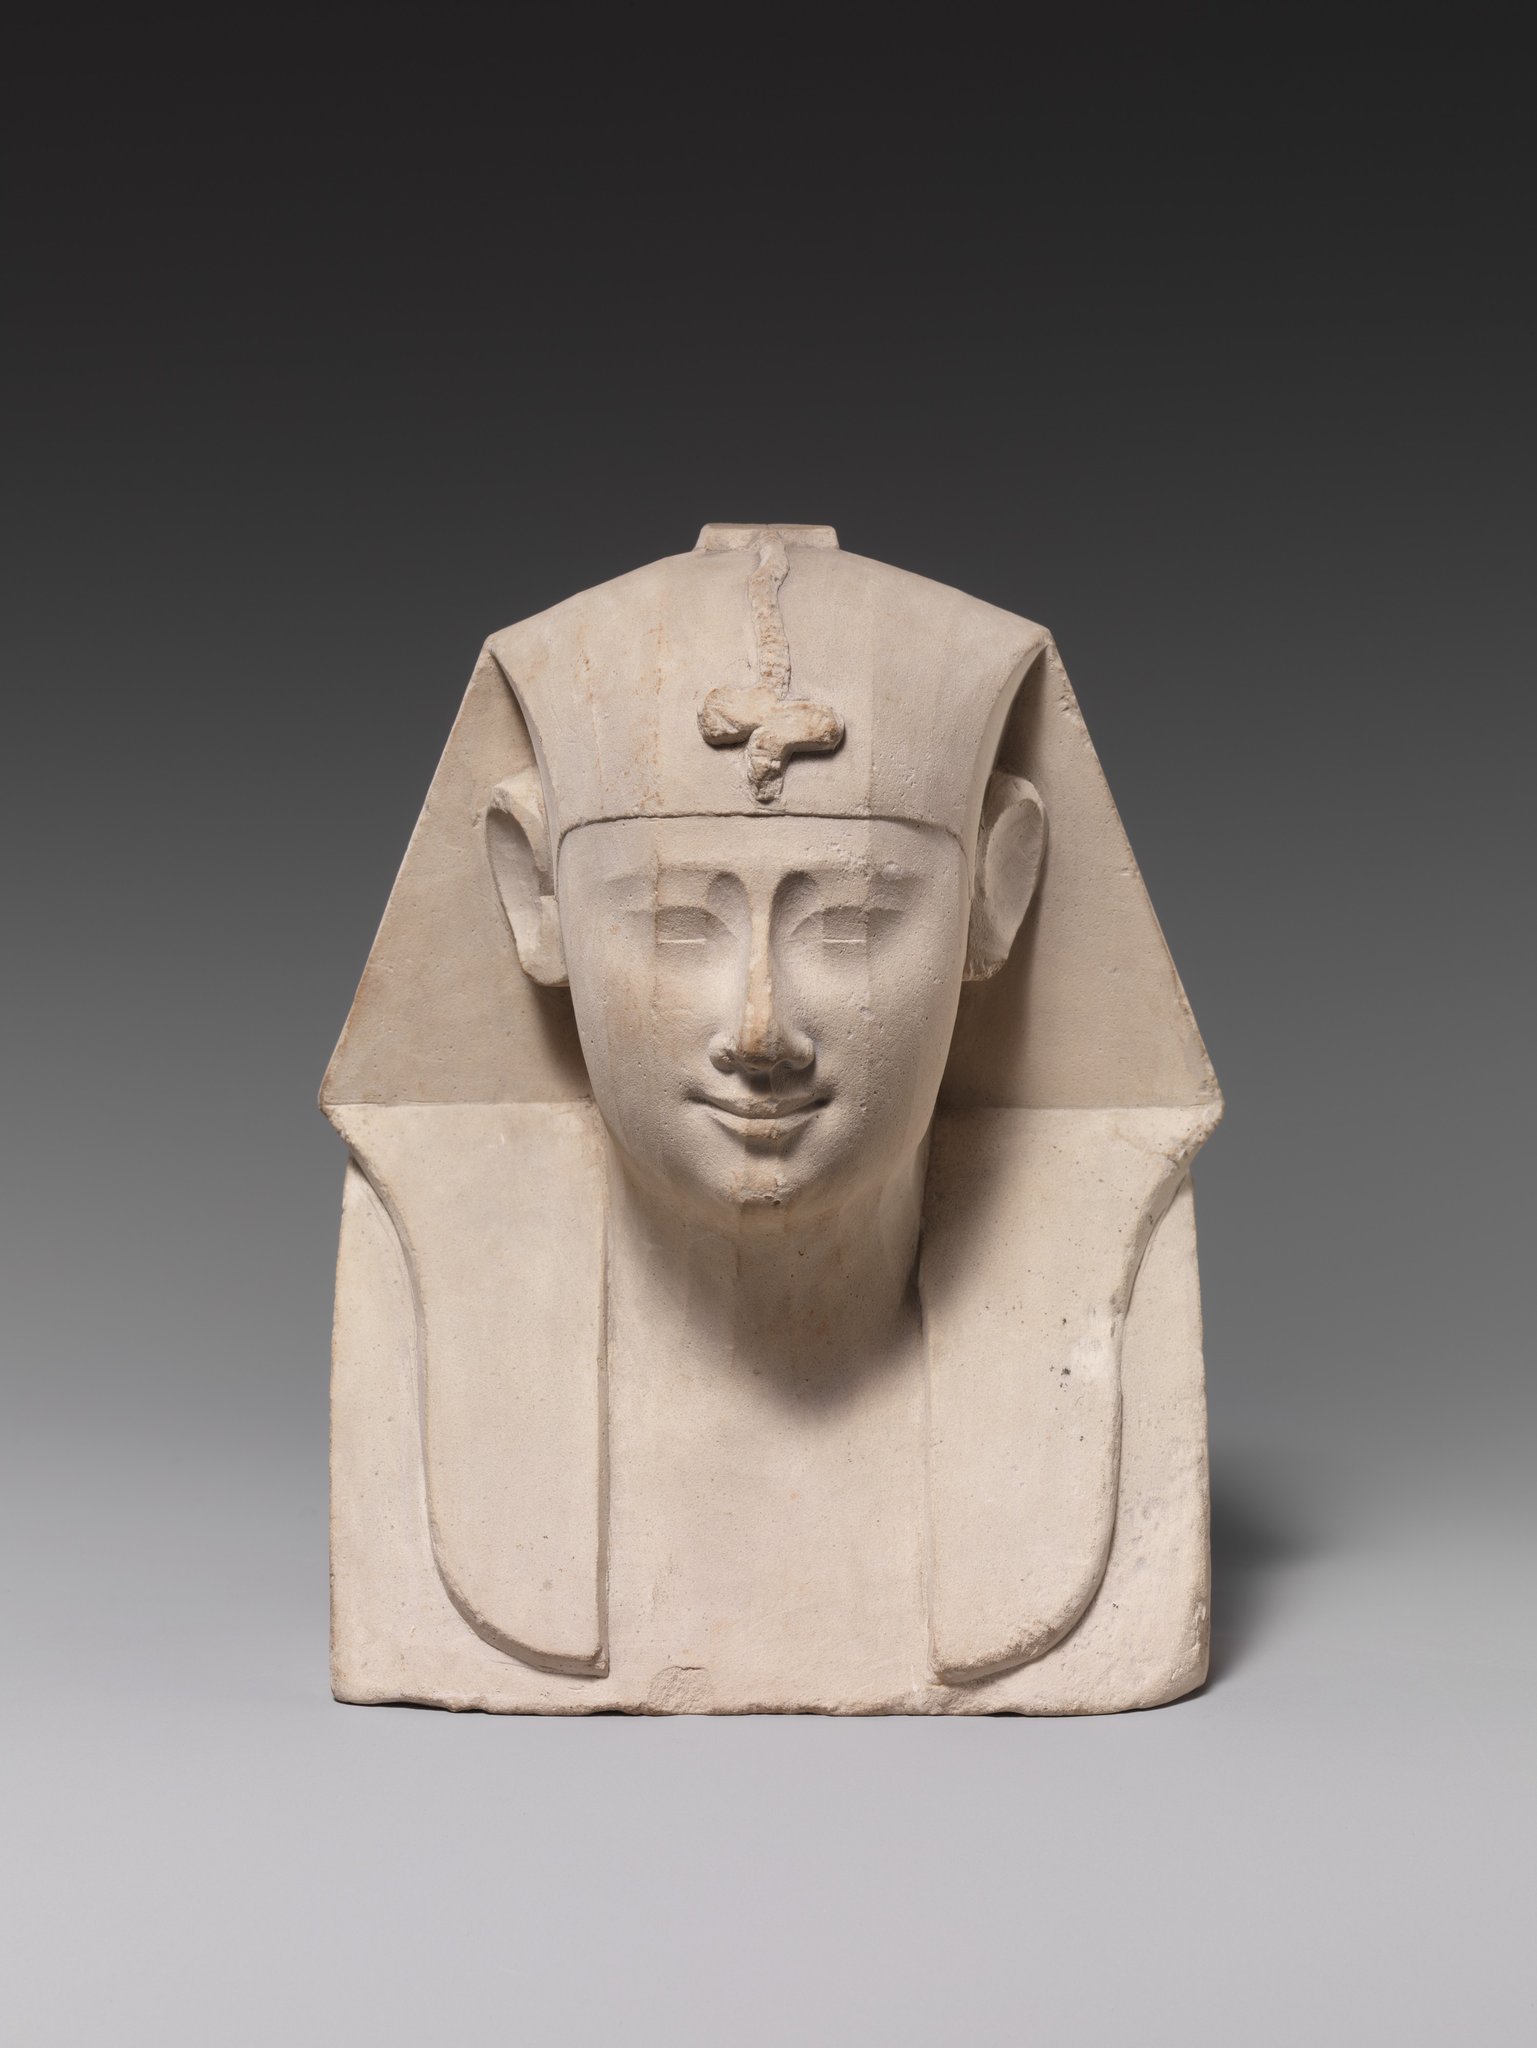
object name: sculptor's model votive, royal bust with atypical snake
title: Bust of a royal figure with downward-hanging snake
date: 400-200 BCE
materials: limestone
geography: egypt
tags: heads,men,snakes